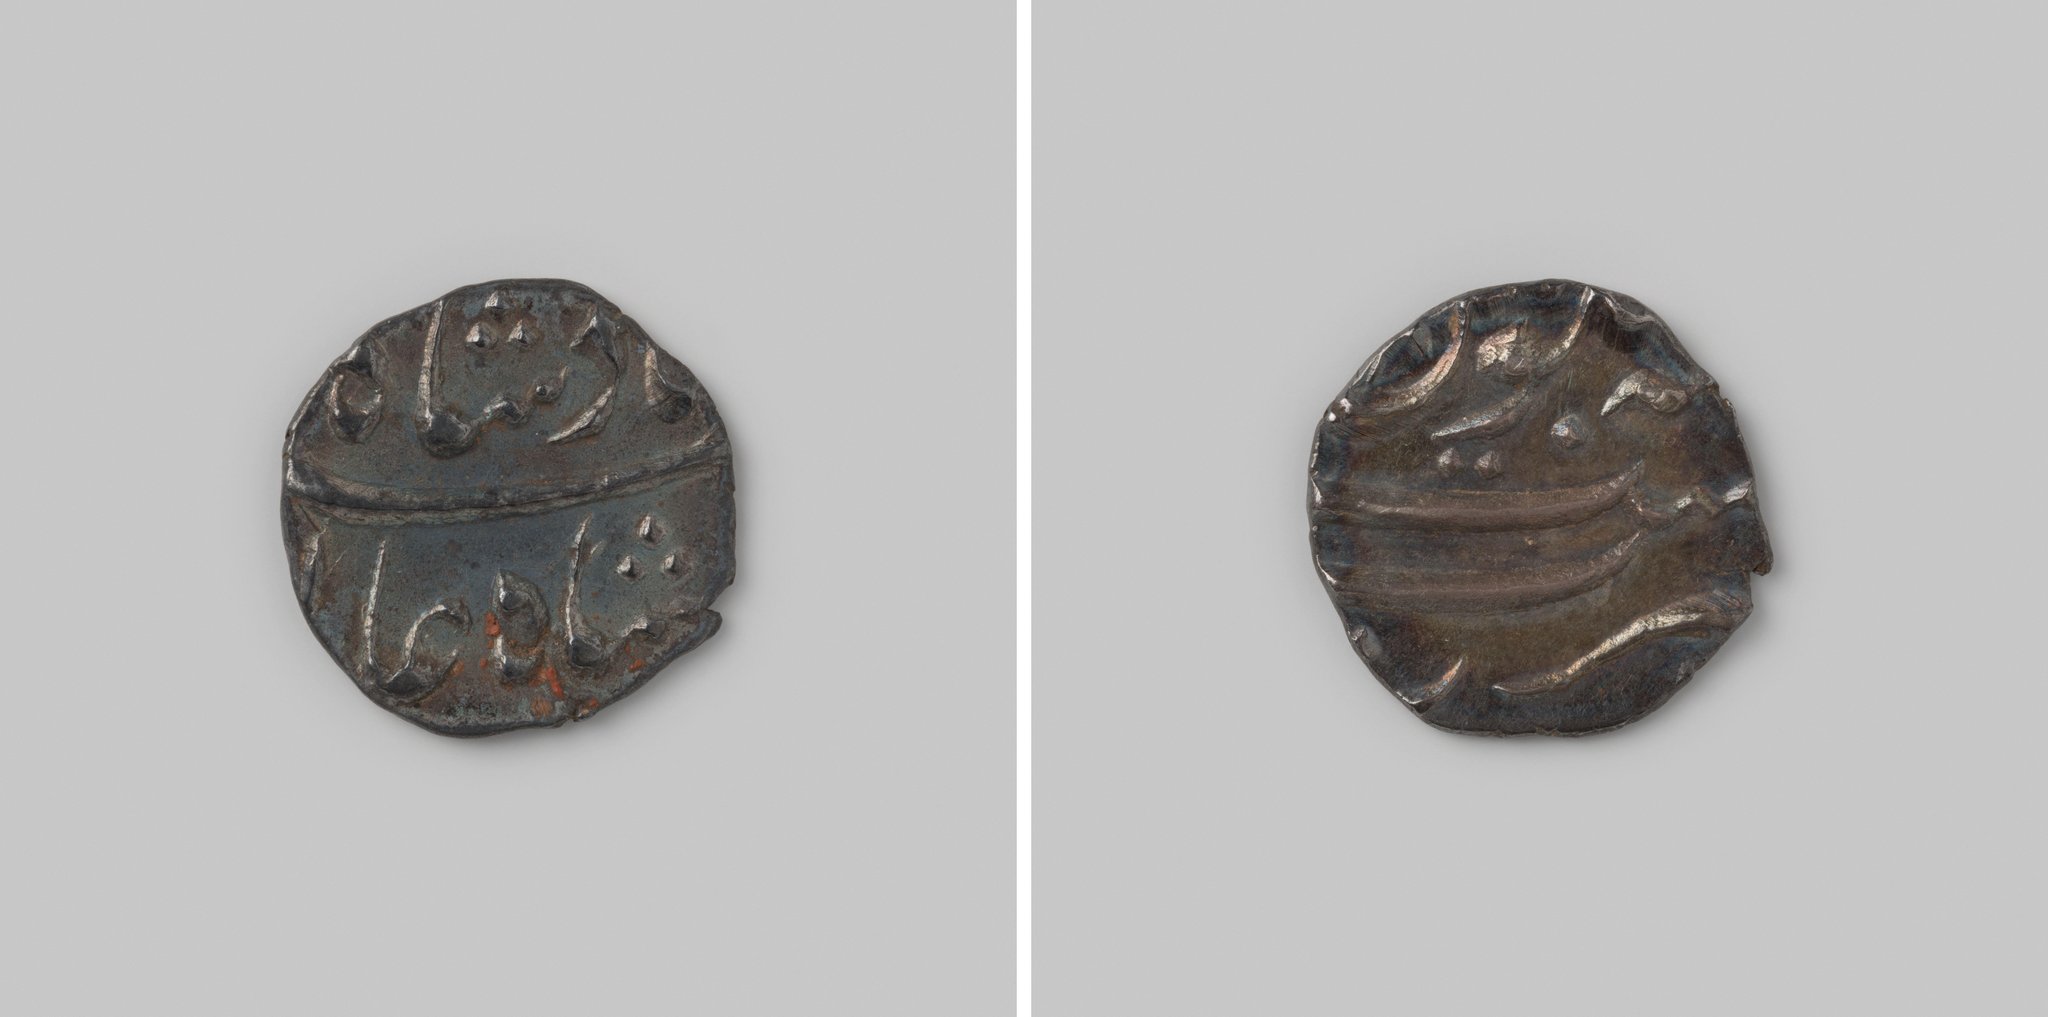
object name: coin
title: 1/8 roepie uit India van sjah Alam II, 1173-1221 [=1759-1806]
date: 1759-1806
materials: silver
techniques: striking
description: Zilveren munt. Voorzijde: in Arabische lettertekens in twee regels opschrift. Keerzijde: in Arabische lettertekens in drie regels opschrift met ondertermineerbare aanduiding jaartal-aanduiding.